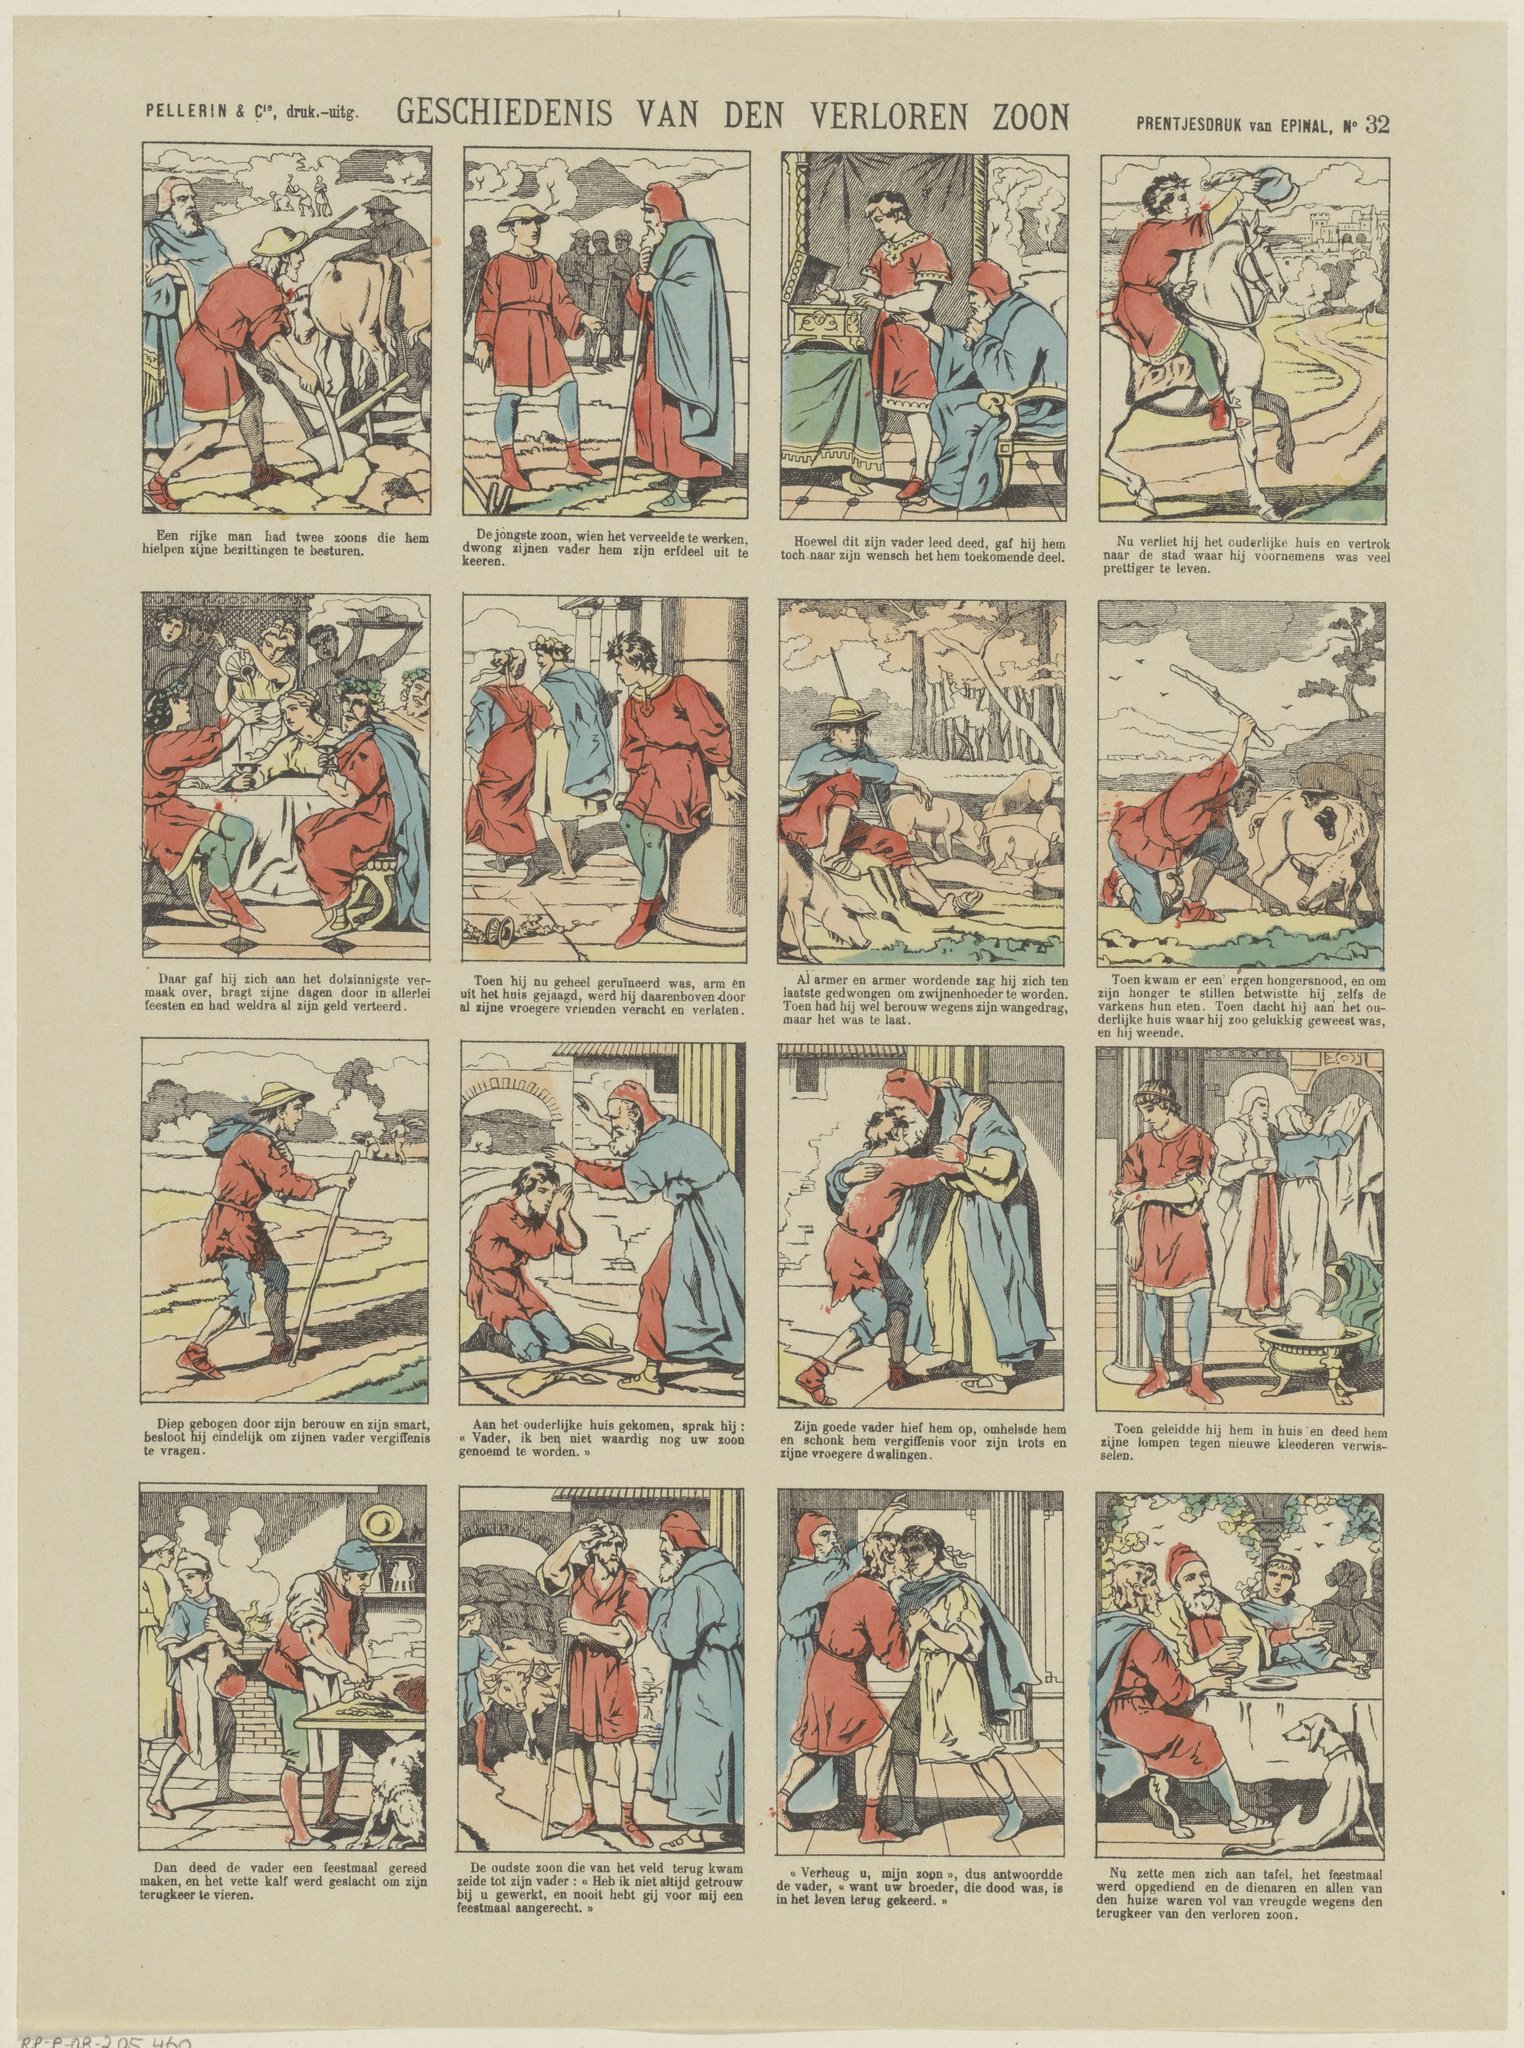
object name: popular print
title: Geschiedenis van den verloren zoon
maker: Anonymous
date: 1902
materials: paper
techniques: colour, letterpress printing, lithograph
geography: epinal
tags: the parable of the prodigal son (luke 15:11-32)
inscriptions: collector's mark: Lugt 2760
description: Blad met 16 voorstellingen uit het verhaal over de verloren zoon. Onder elke afbeelding een onderschrift. Genummerd rechtsboven: No 32.